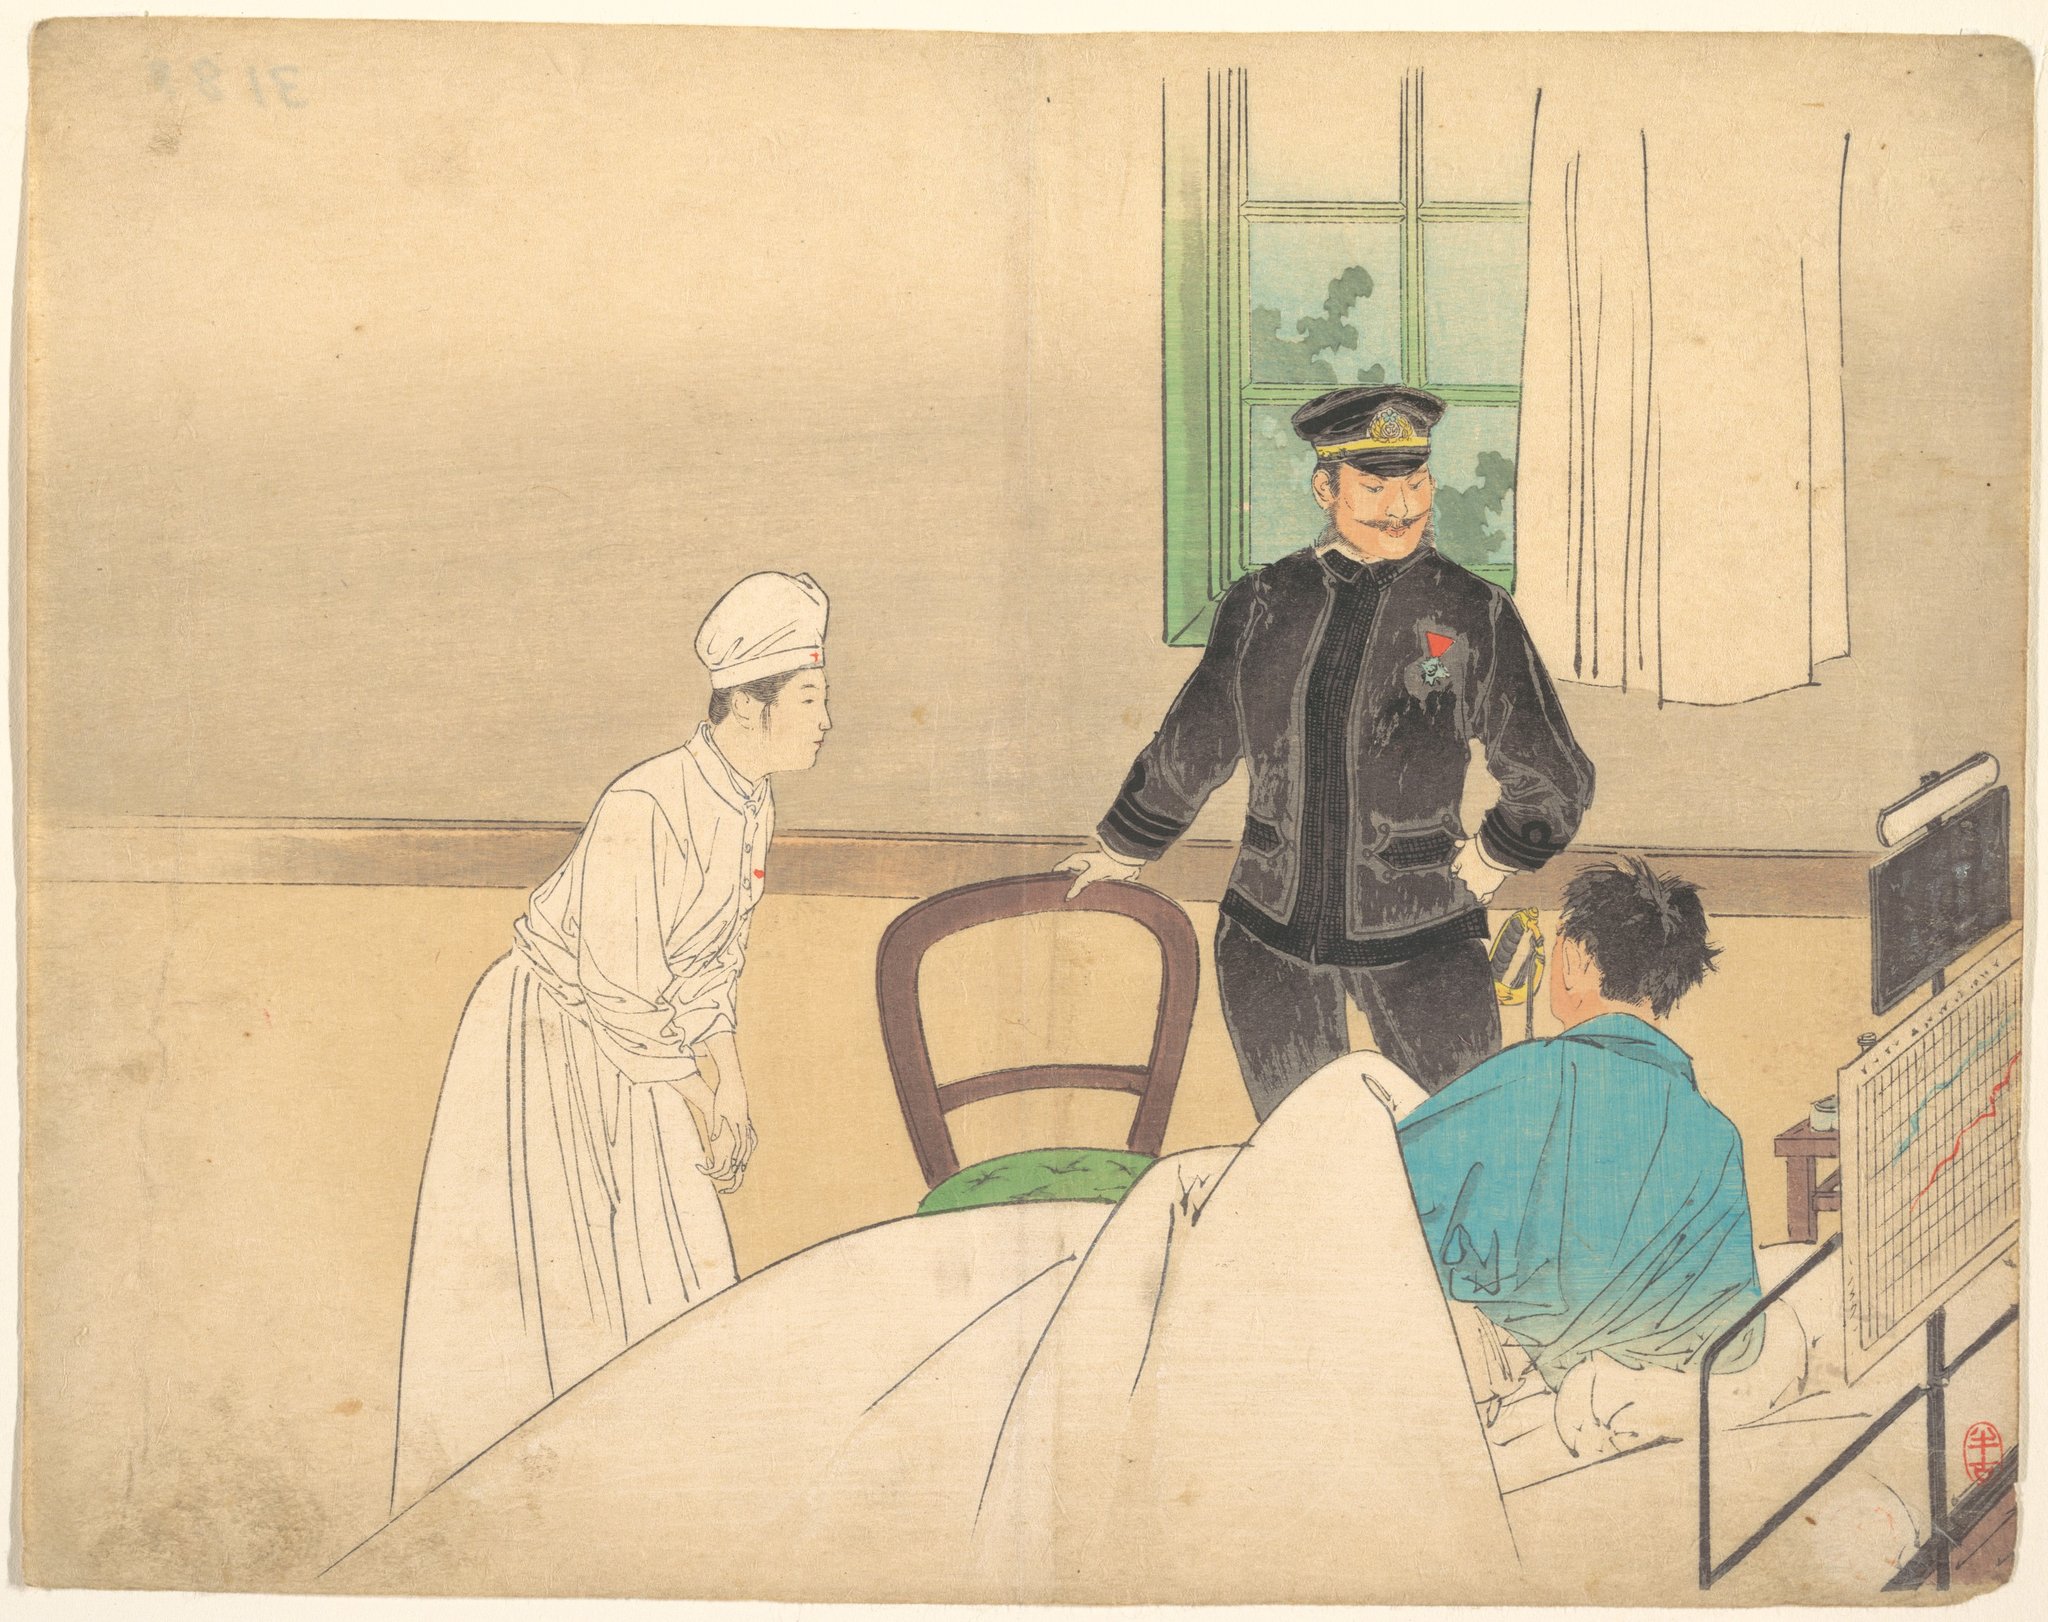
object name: print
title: The Torpedo Officer (Suirai shikan), frontispiece illustration from the literary magazine Bungei kurabu, vol. 1, no. 8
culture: japanese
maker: kajita hanko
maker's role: artist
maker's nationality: japanese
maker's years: 1870-1917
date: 1900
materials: ink, paper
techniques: woodblock print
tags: hospitals,illness,men,women